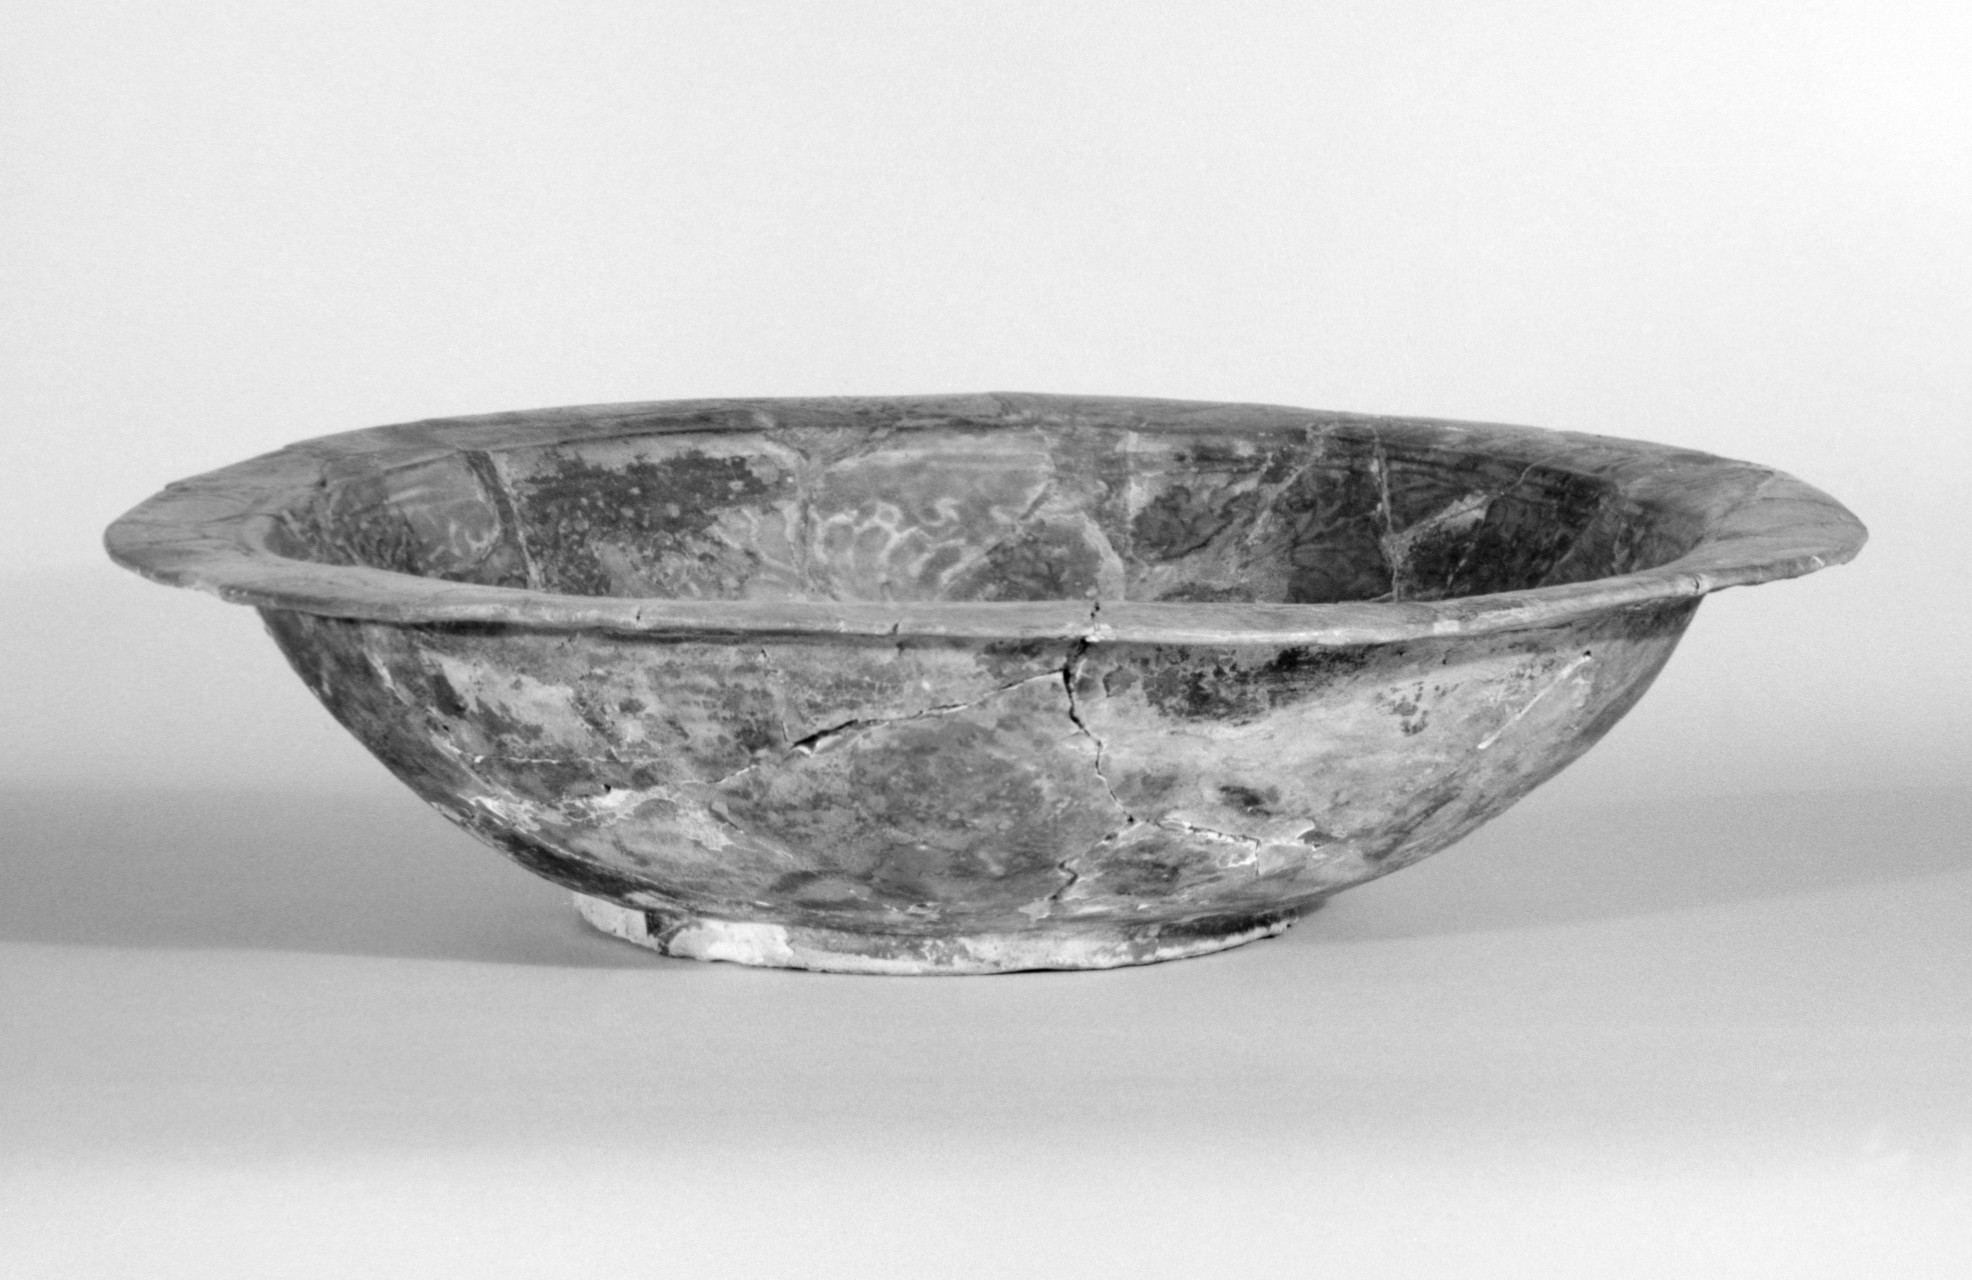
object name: bowl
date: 1101-1300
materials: earthenware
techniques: carving, incising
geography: iran